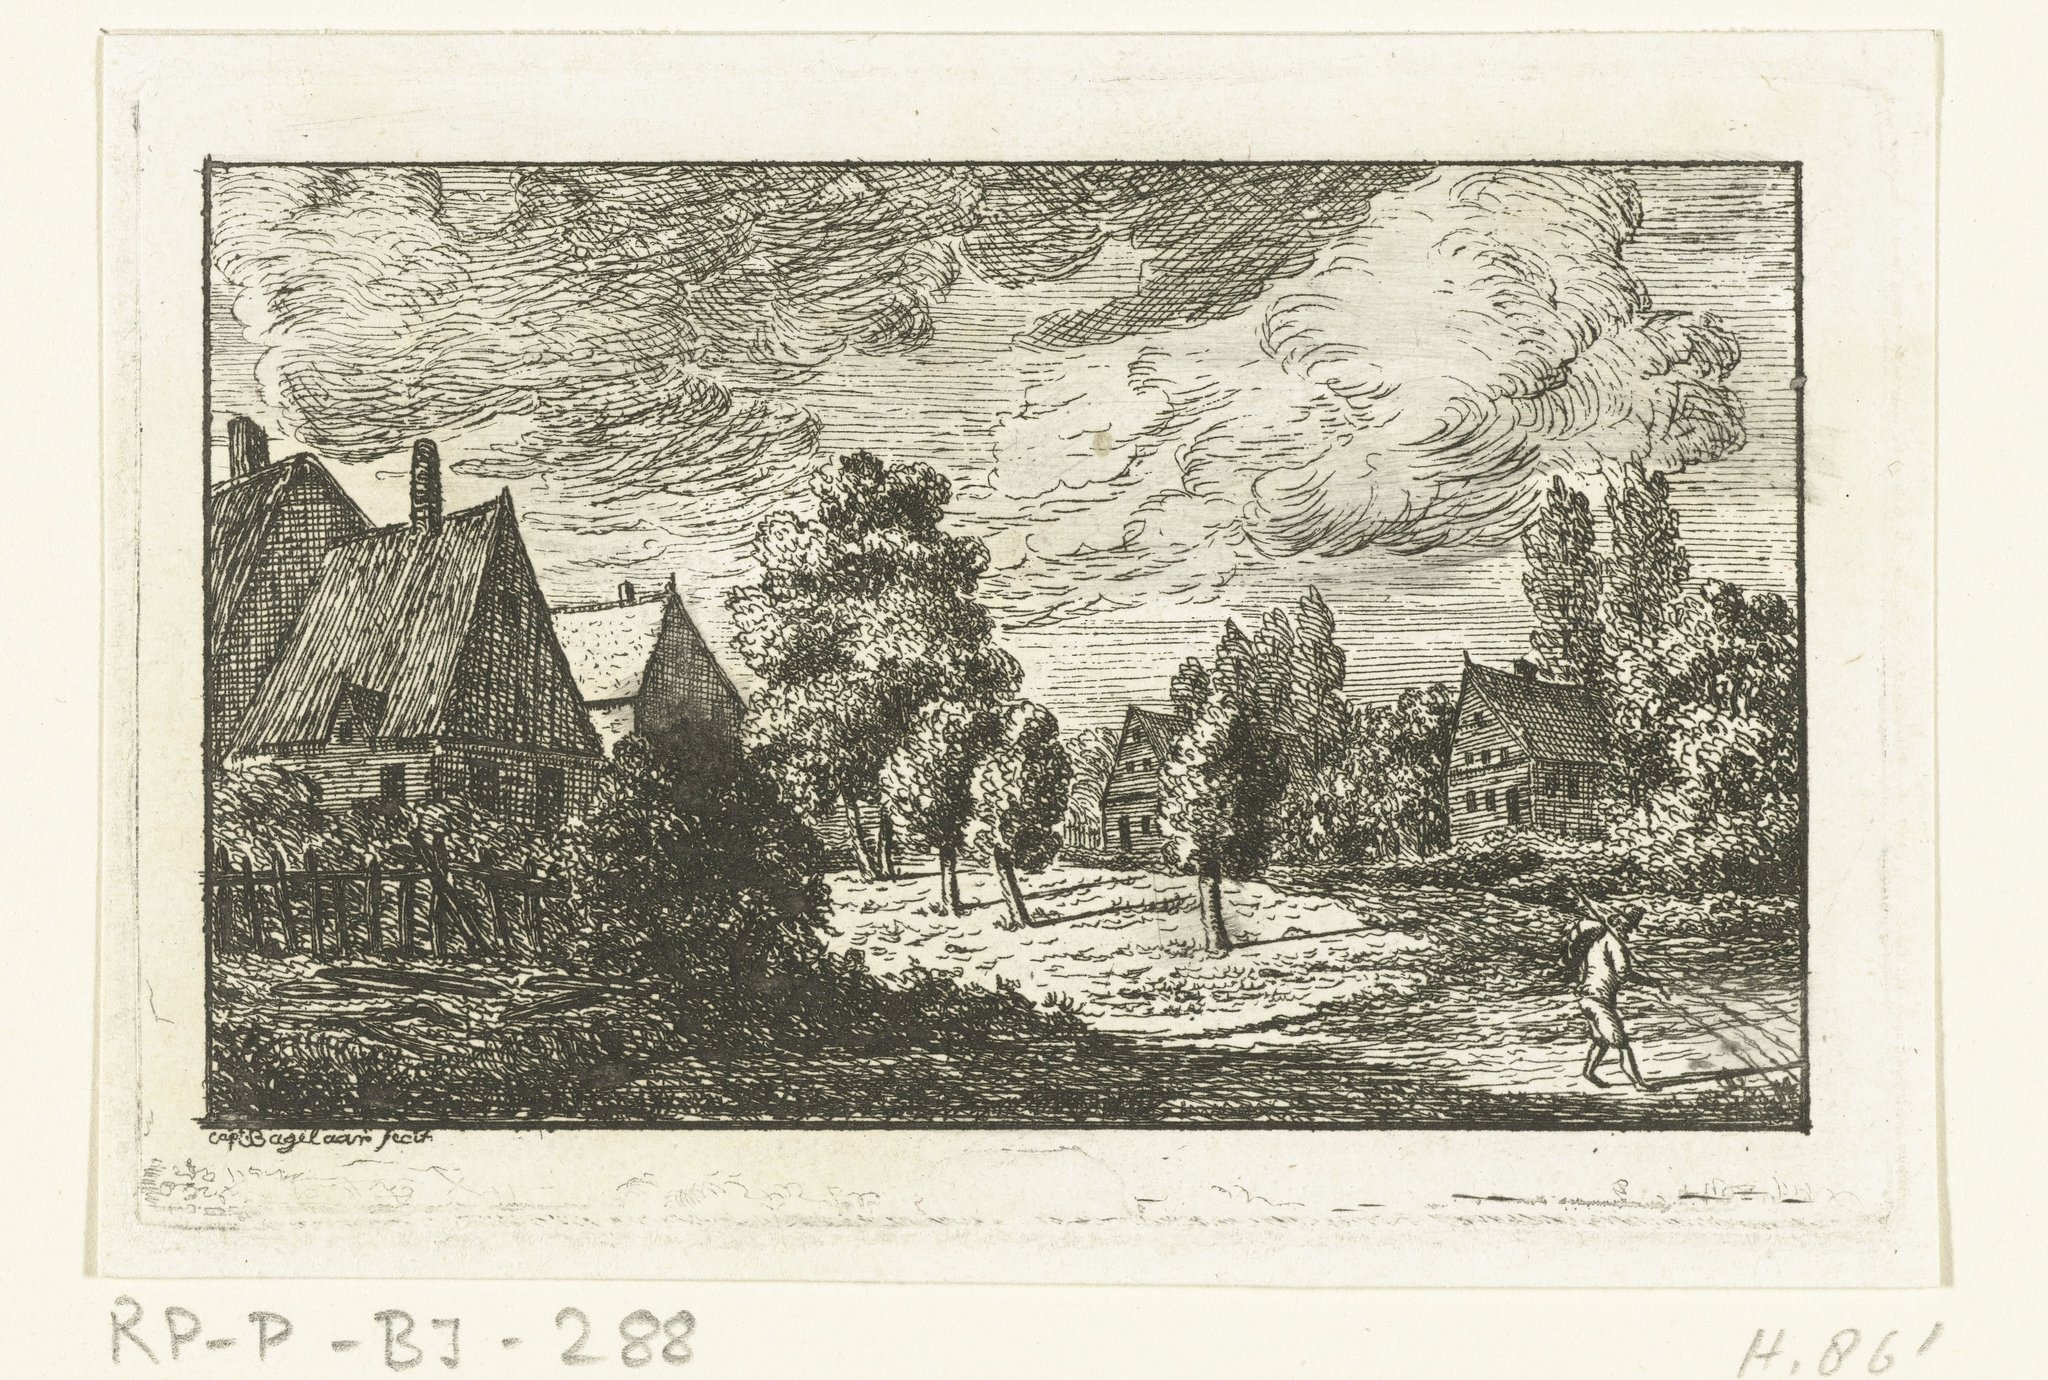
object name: print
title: Gezicht op Lechhausen bij Augsburg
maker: ernst willem jan bagelaar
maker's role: draughtsman, print maker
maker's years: 1775-1837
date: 1798-1837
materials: paper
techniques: drypoint, etching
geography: netherlands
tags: village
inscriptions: collector's mark: Lugt 2228